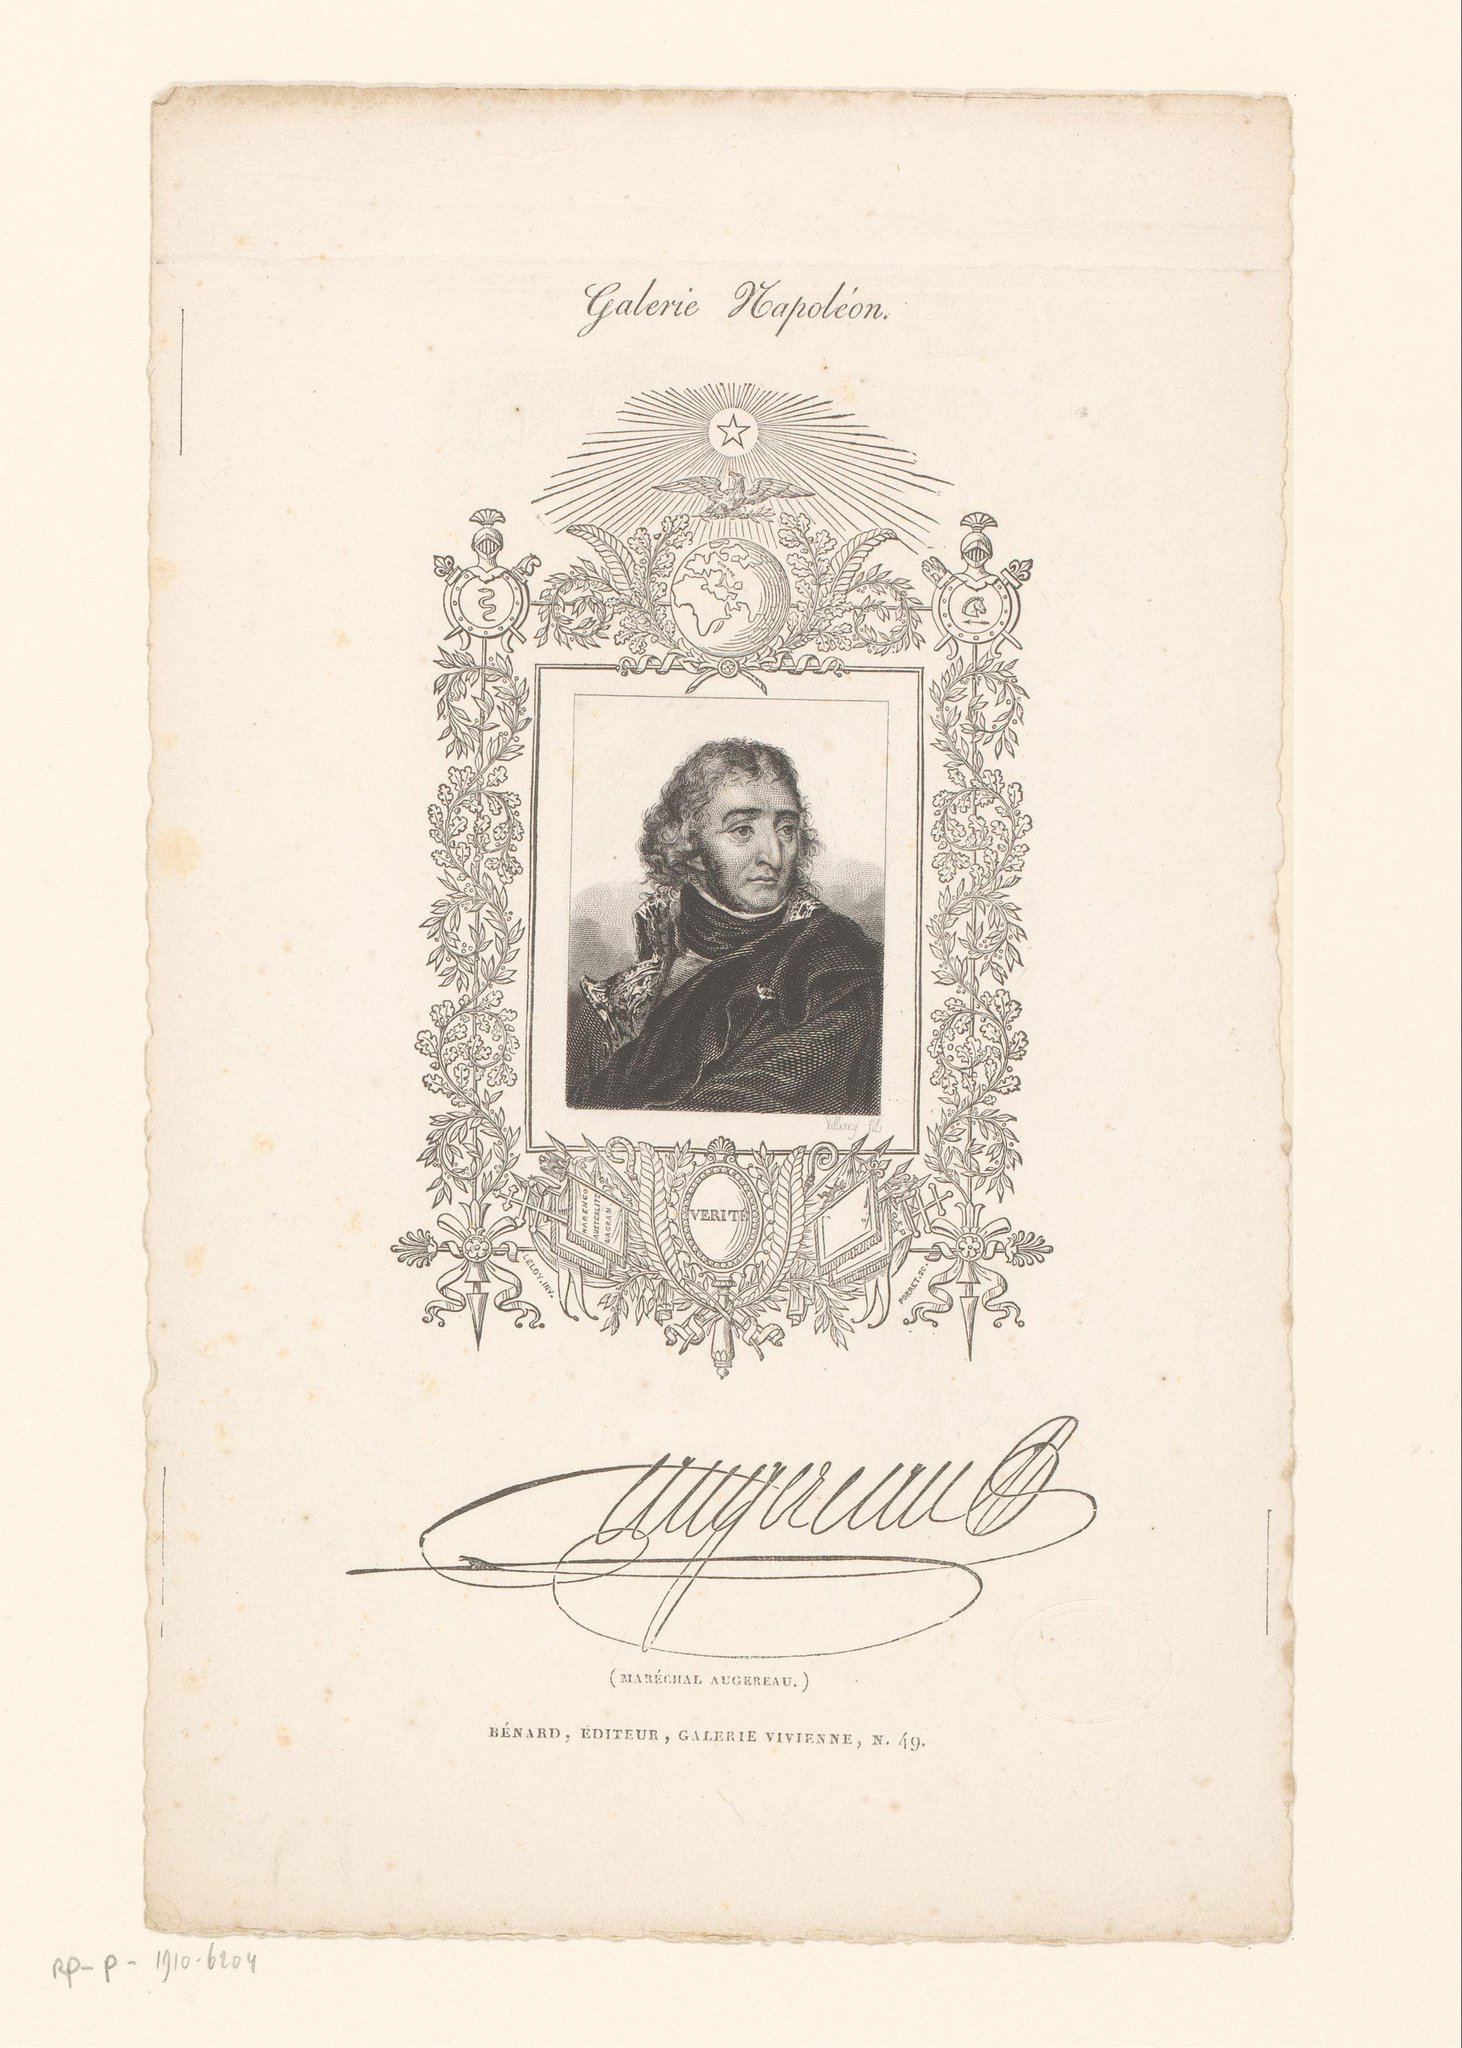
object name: print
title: Portret van Pierre François Charles Augereau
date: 1829-1830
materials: paper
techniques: etching, engraving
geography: paris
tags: paris, politician, commander-in-chief, general, marshal, historical persons, globe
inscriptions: check stamp: ‘Galerie Vivienne/ no: 49 /Bénard’, collector's mark: Lugt 2228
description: Dit portret maakt deel uit van de serie "Galerie Napoléon", een collectie van honderd portretten van vooraanstaande figuren uit de omgeving van Napoleon Bonaparte. De serie werd uitgegeven door Bénard in Parijs in 1829-30.